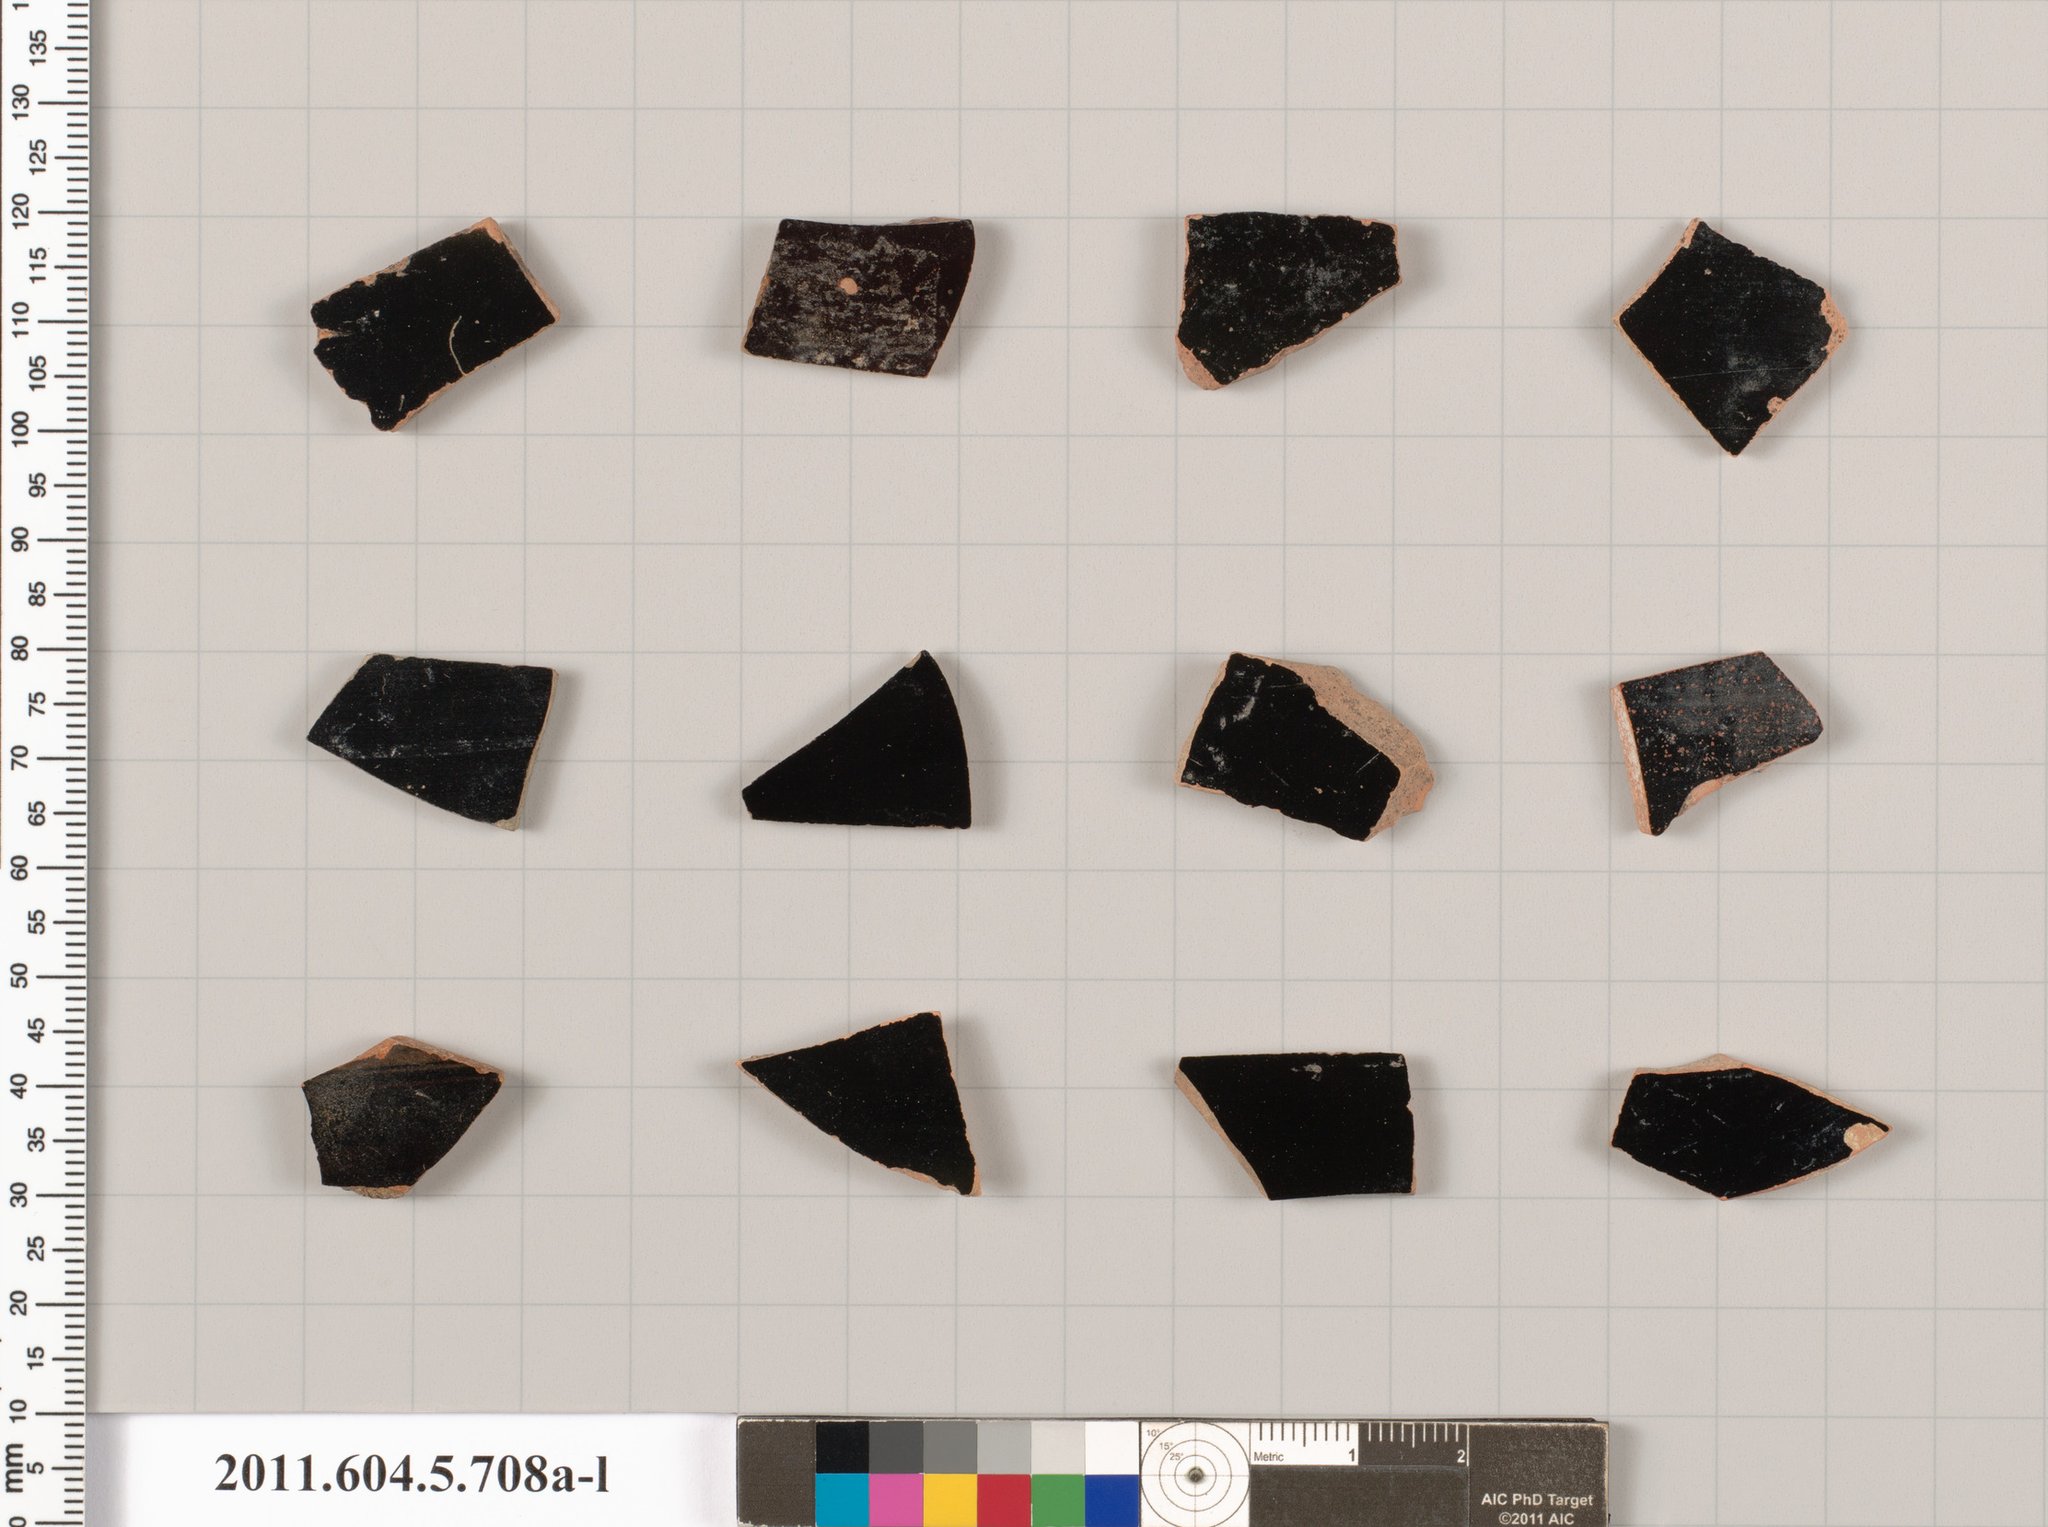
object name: kylix fragment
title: Terracotta fragments of kylikes (drinking cups)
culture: greek, attic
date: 600-401 BCE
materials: terracotta